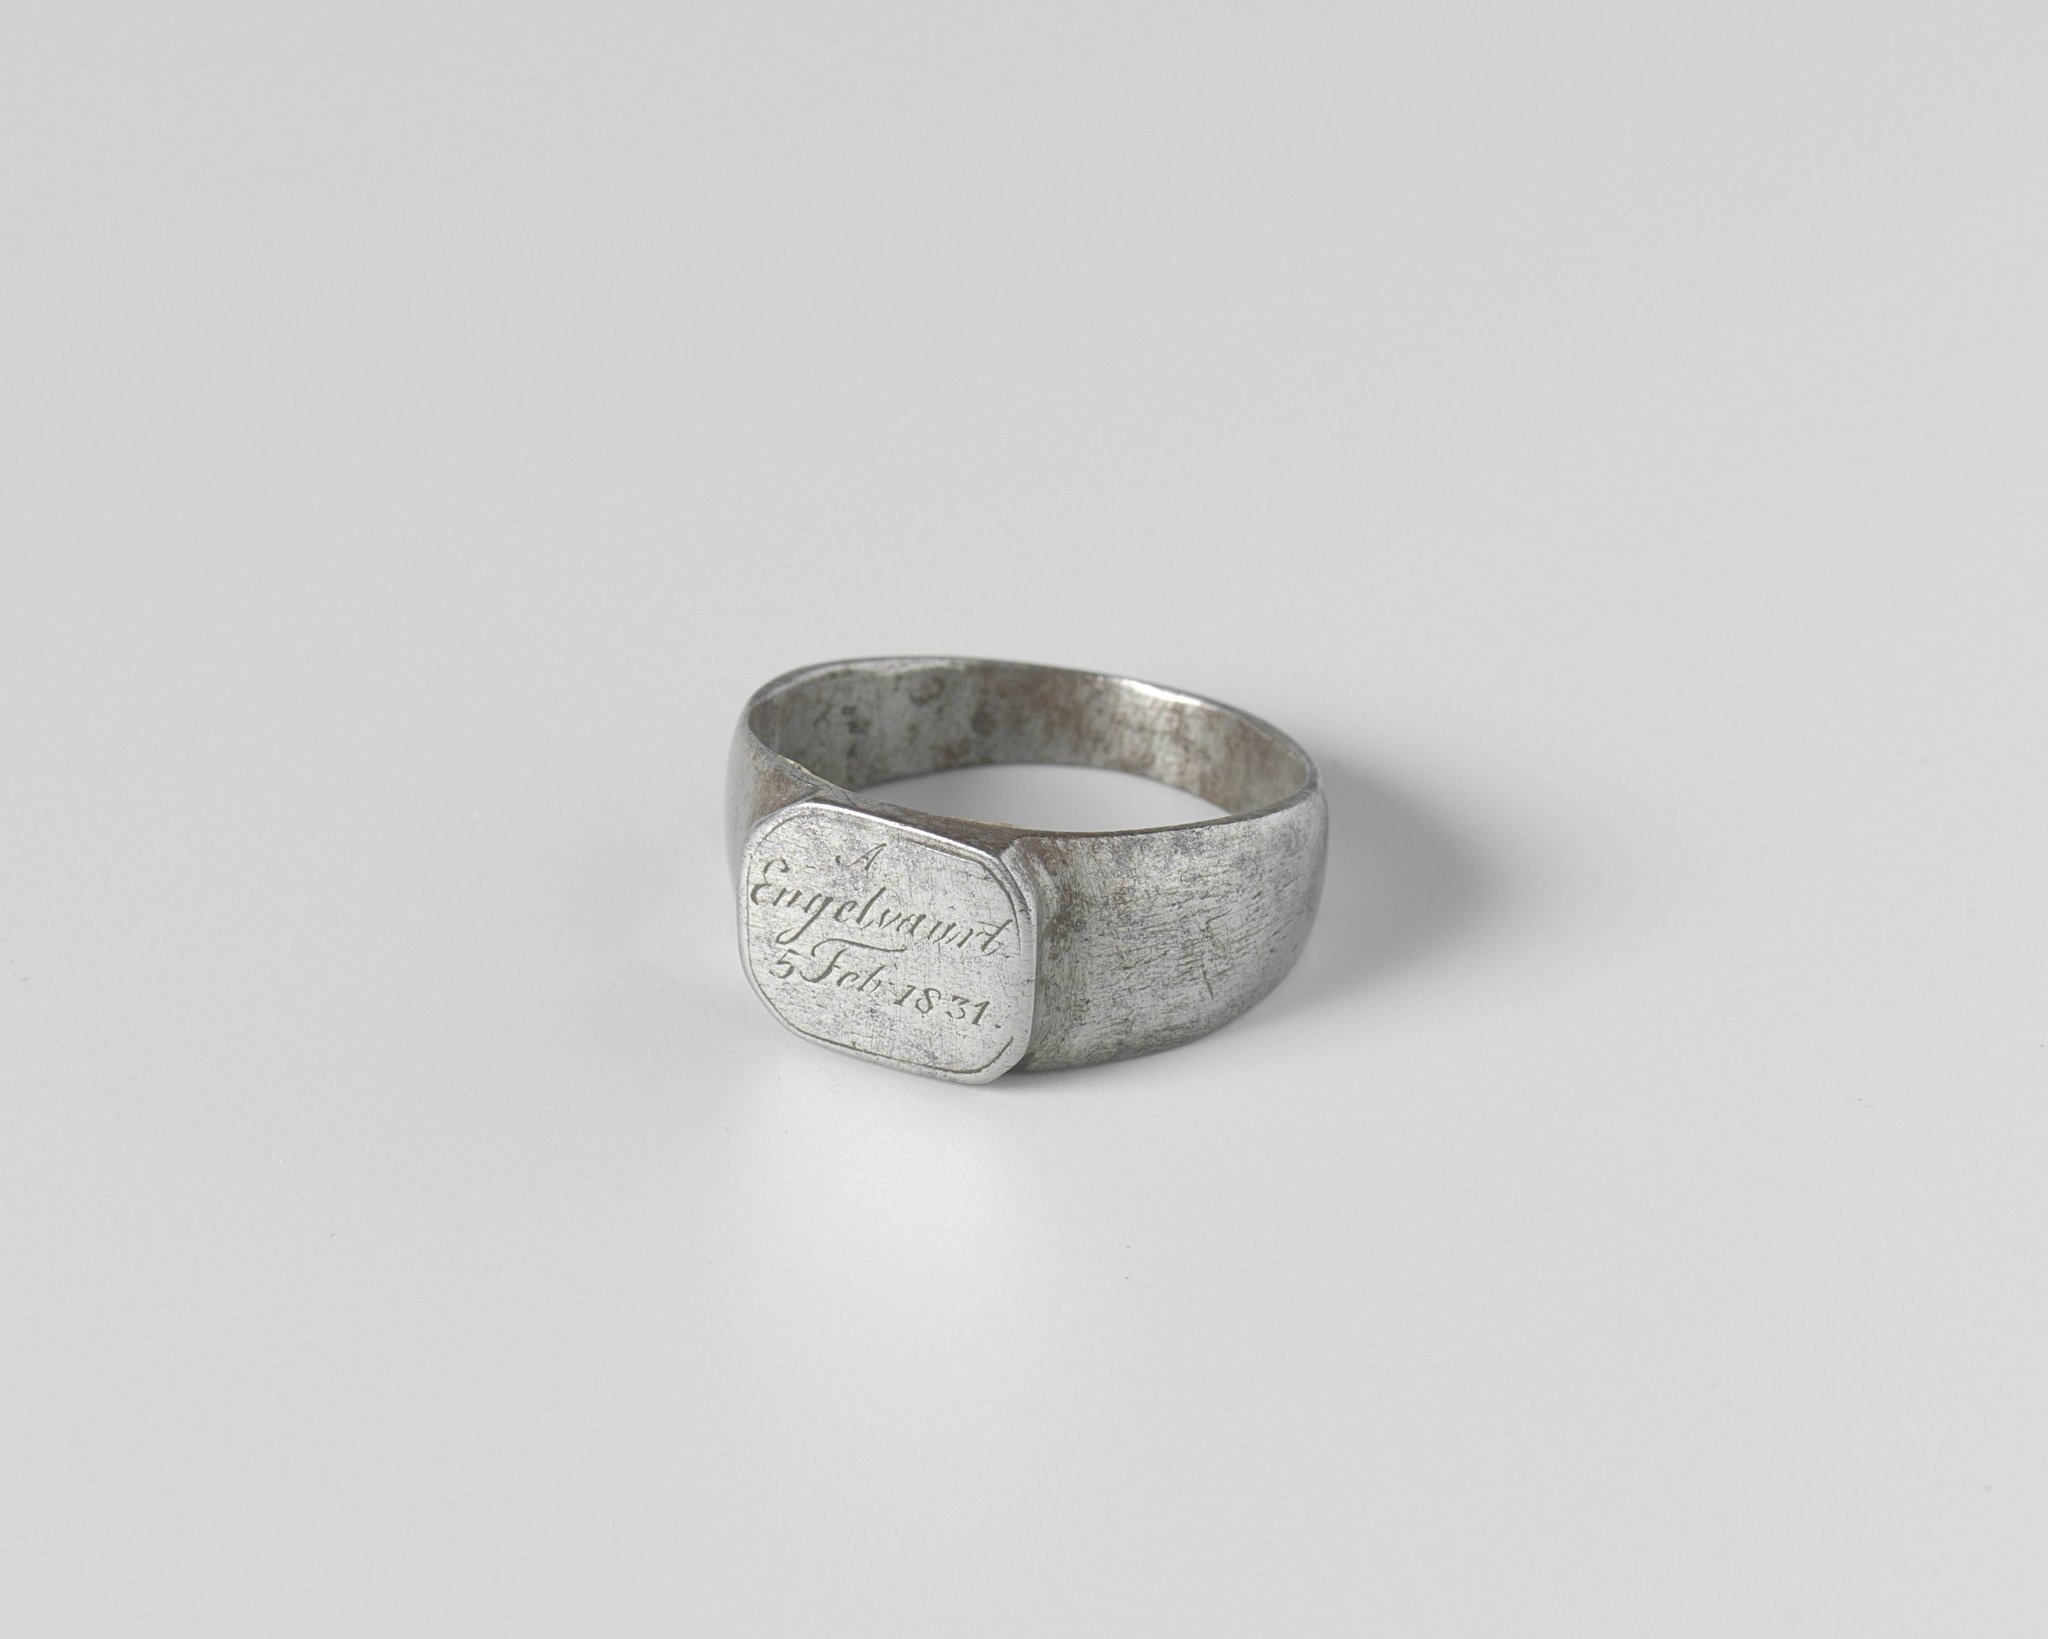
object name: ring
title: Ring van ijzer van de kanonneerboot No. 2 van J.C.J. van Speyk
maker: Anonymous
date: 1831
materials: iron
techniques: forging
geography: netherlands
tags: jan van speyk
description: On 5 October 1833 the amount raised by the lottery was announced. After costs the lottery made ? 6484,98. A total of 5723 tickets had been sold and 911 prizes awarded.